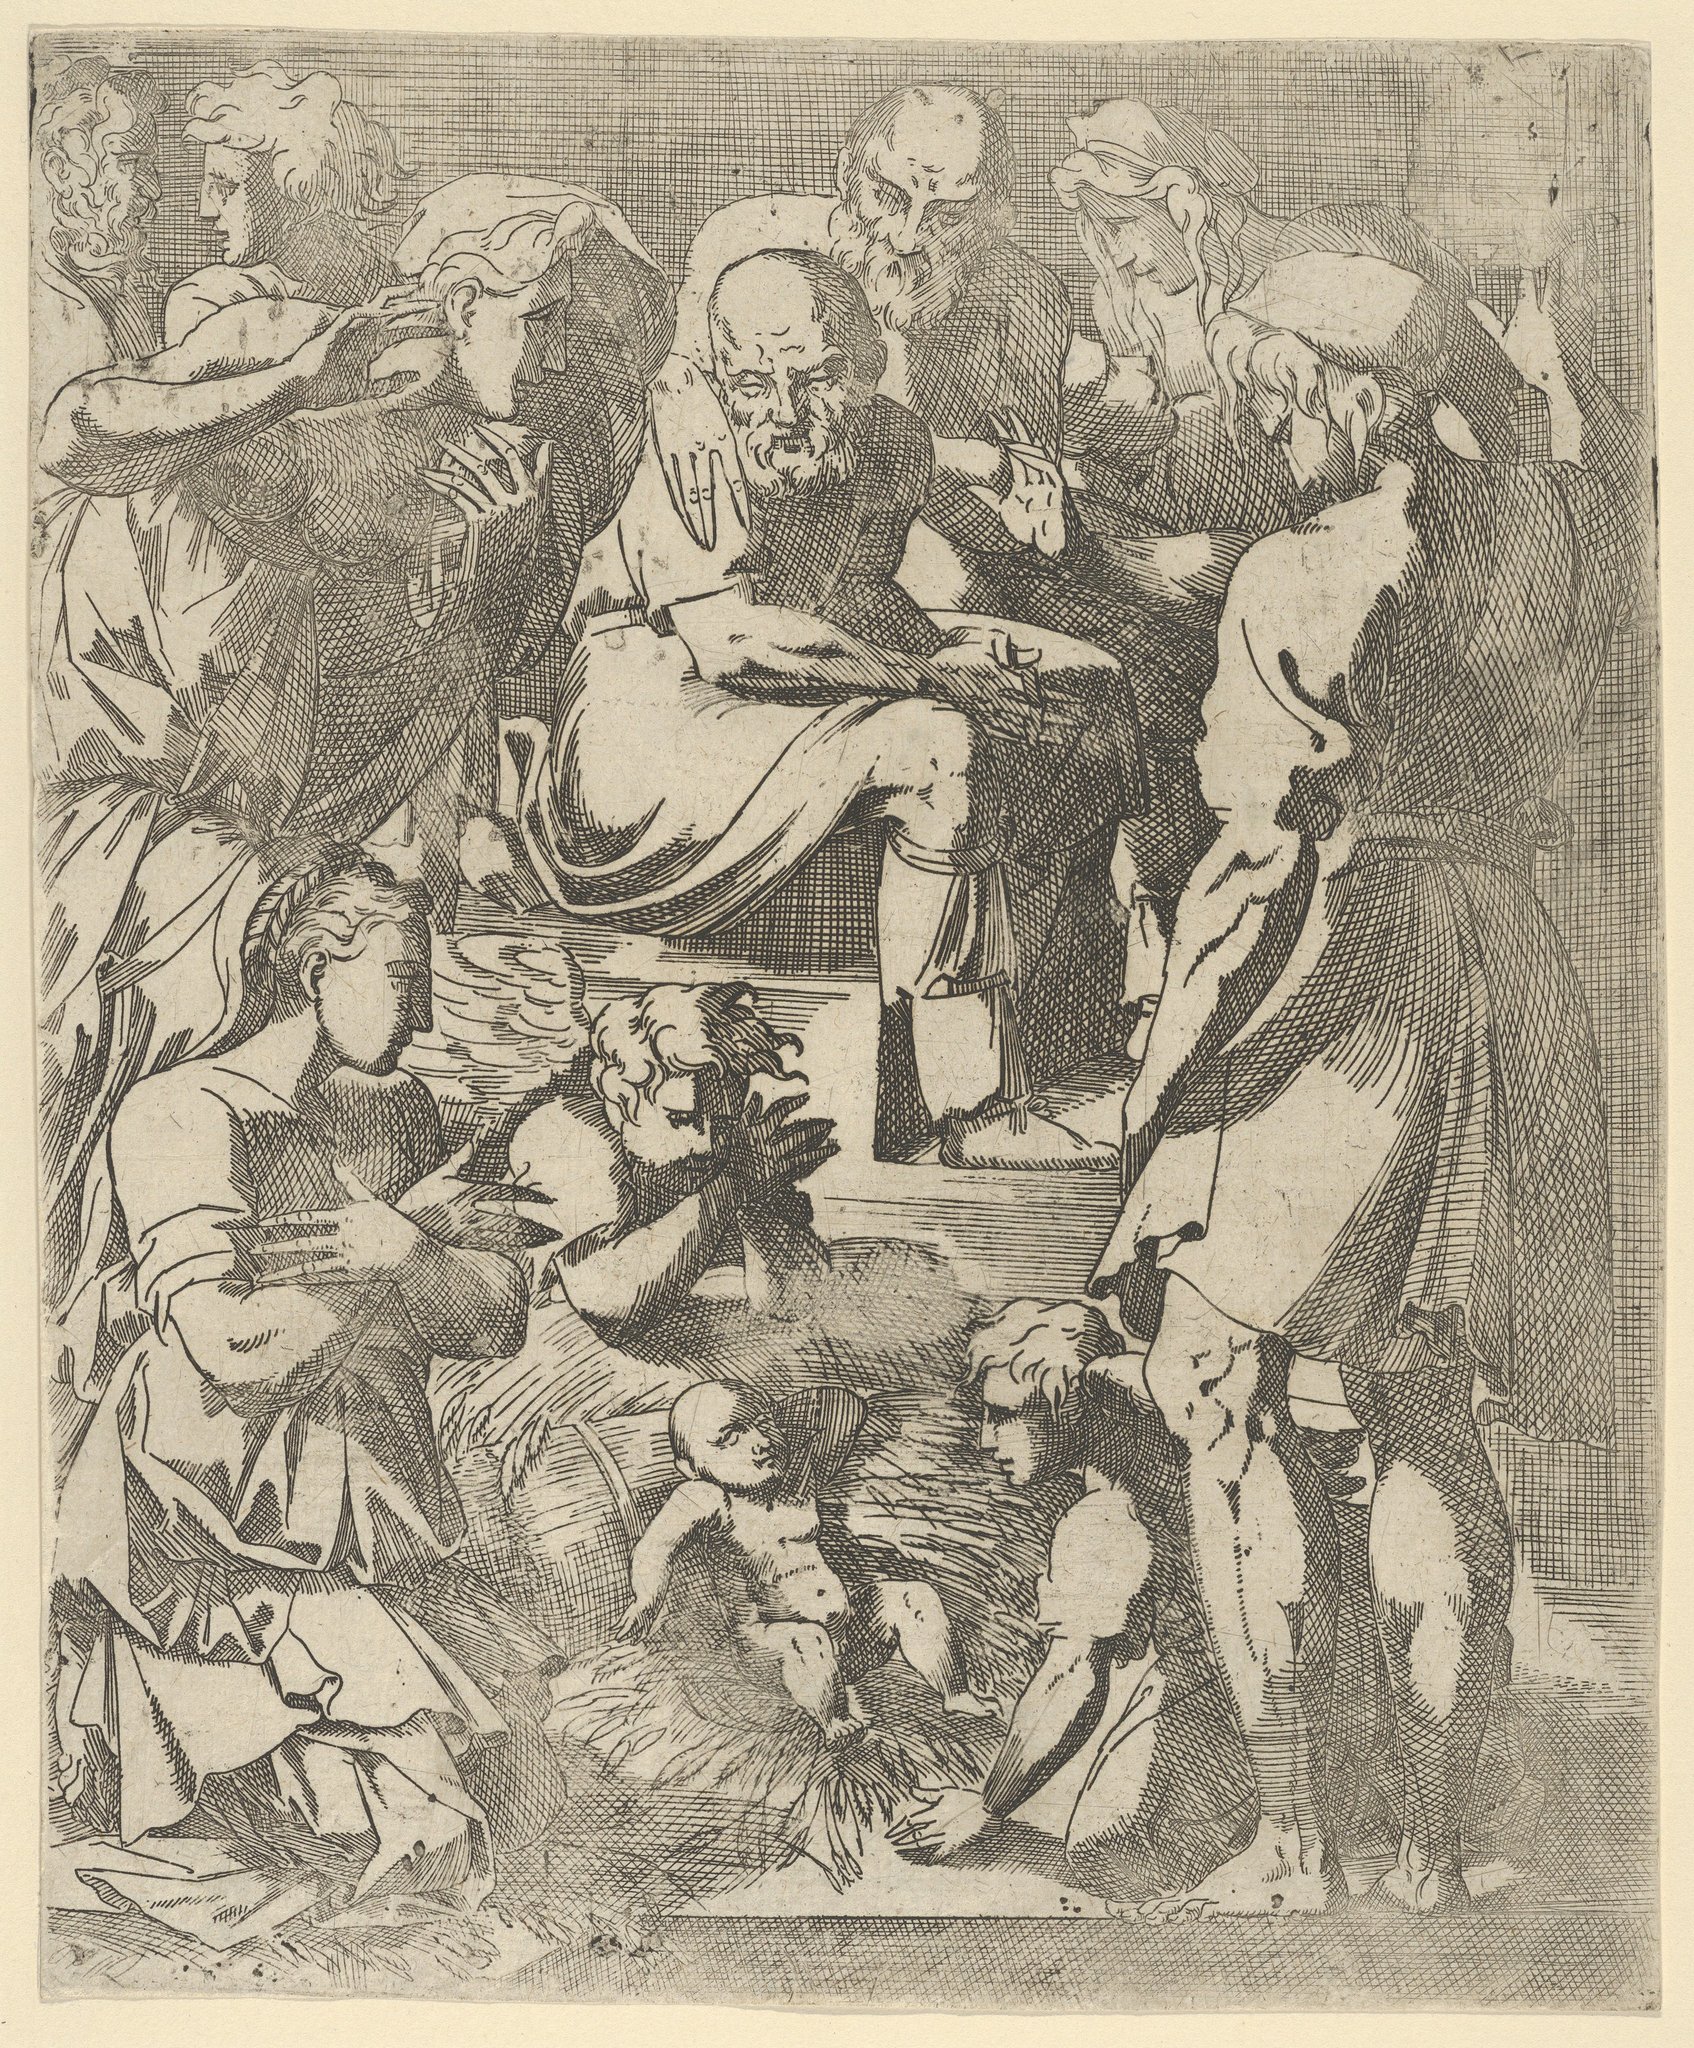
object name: print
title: The Nativity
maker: geoffroy dumoûtier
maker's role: artist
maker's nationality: french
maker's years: 1530-1578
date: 1544-1548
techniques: etching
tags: nativity